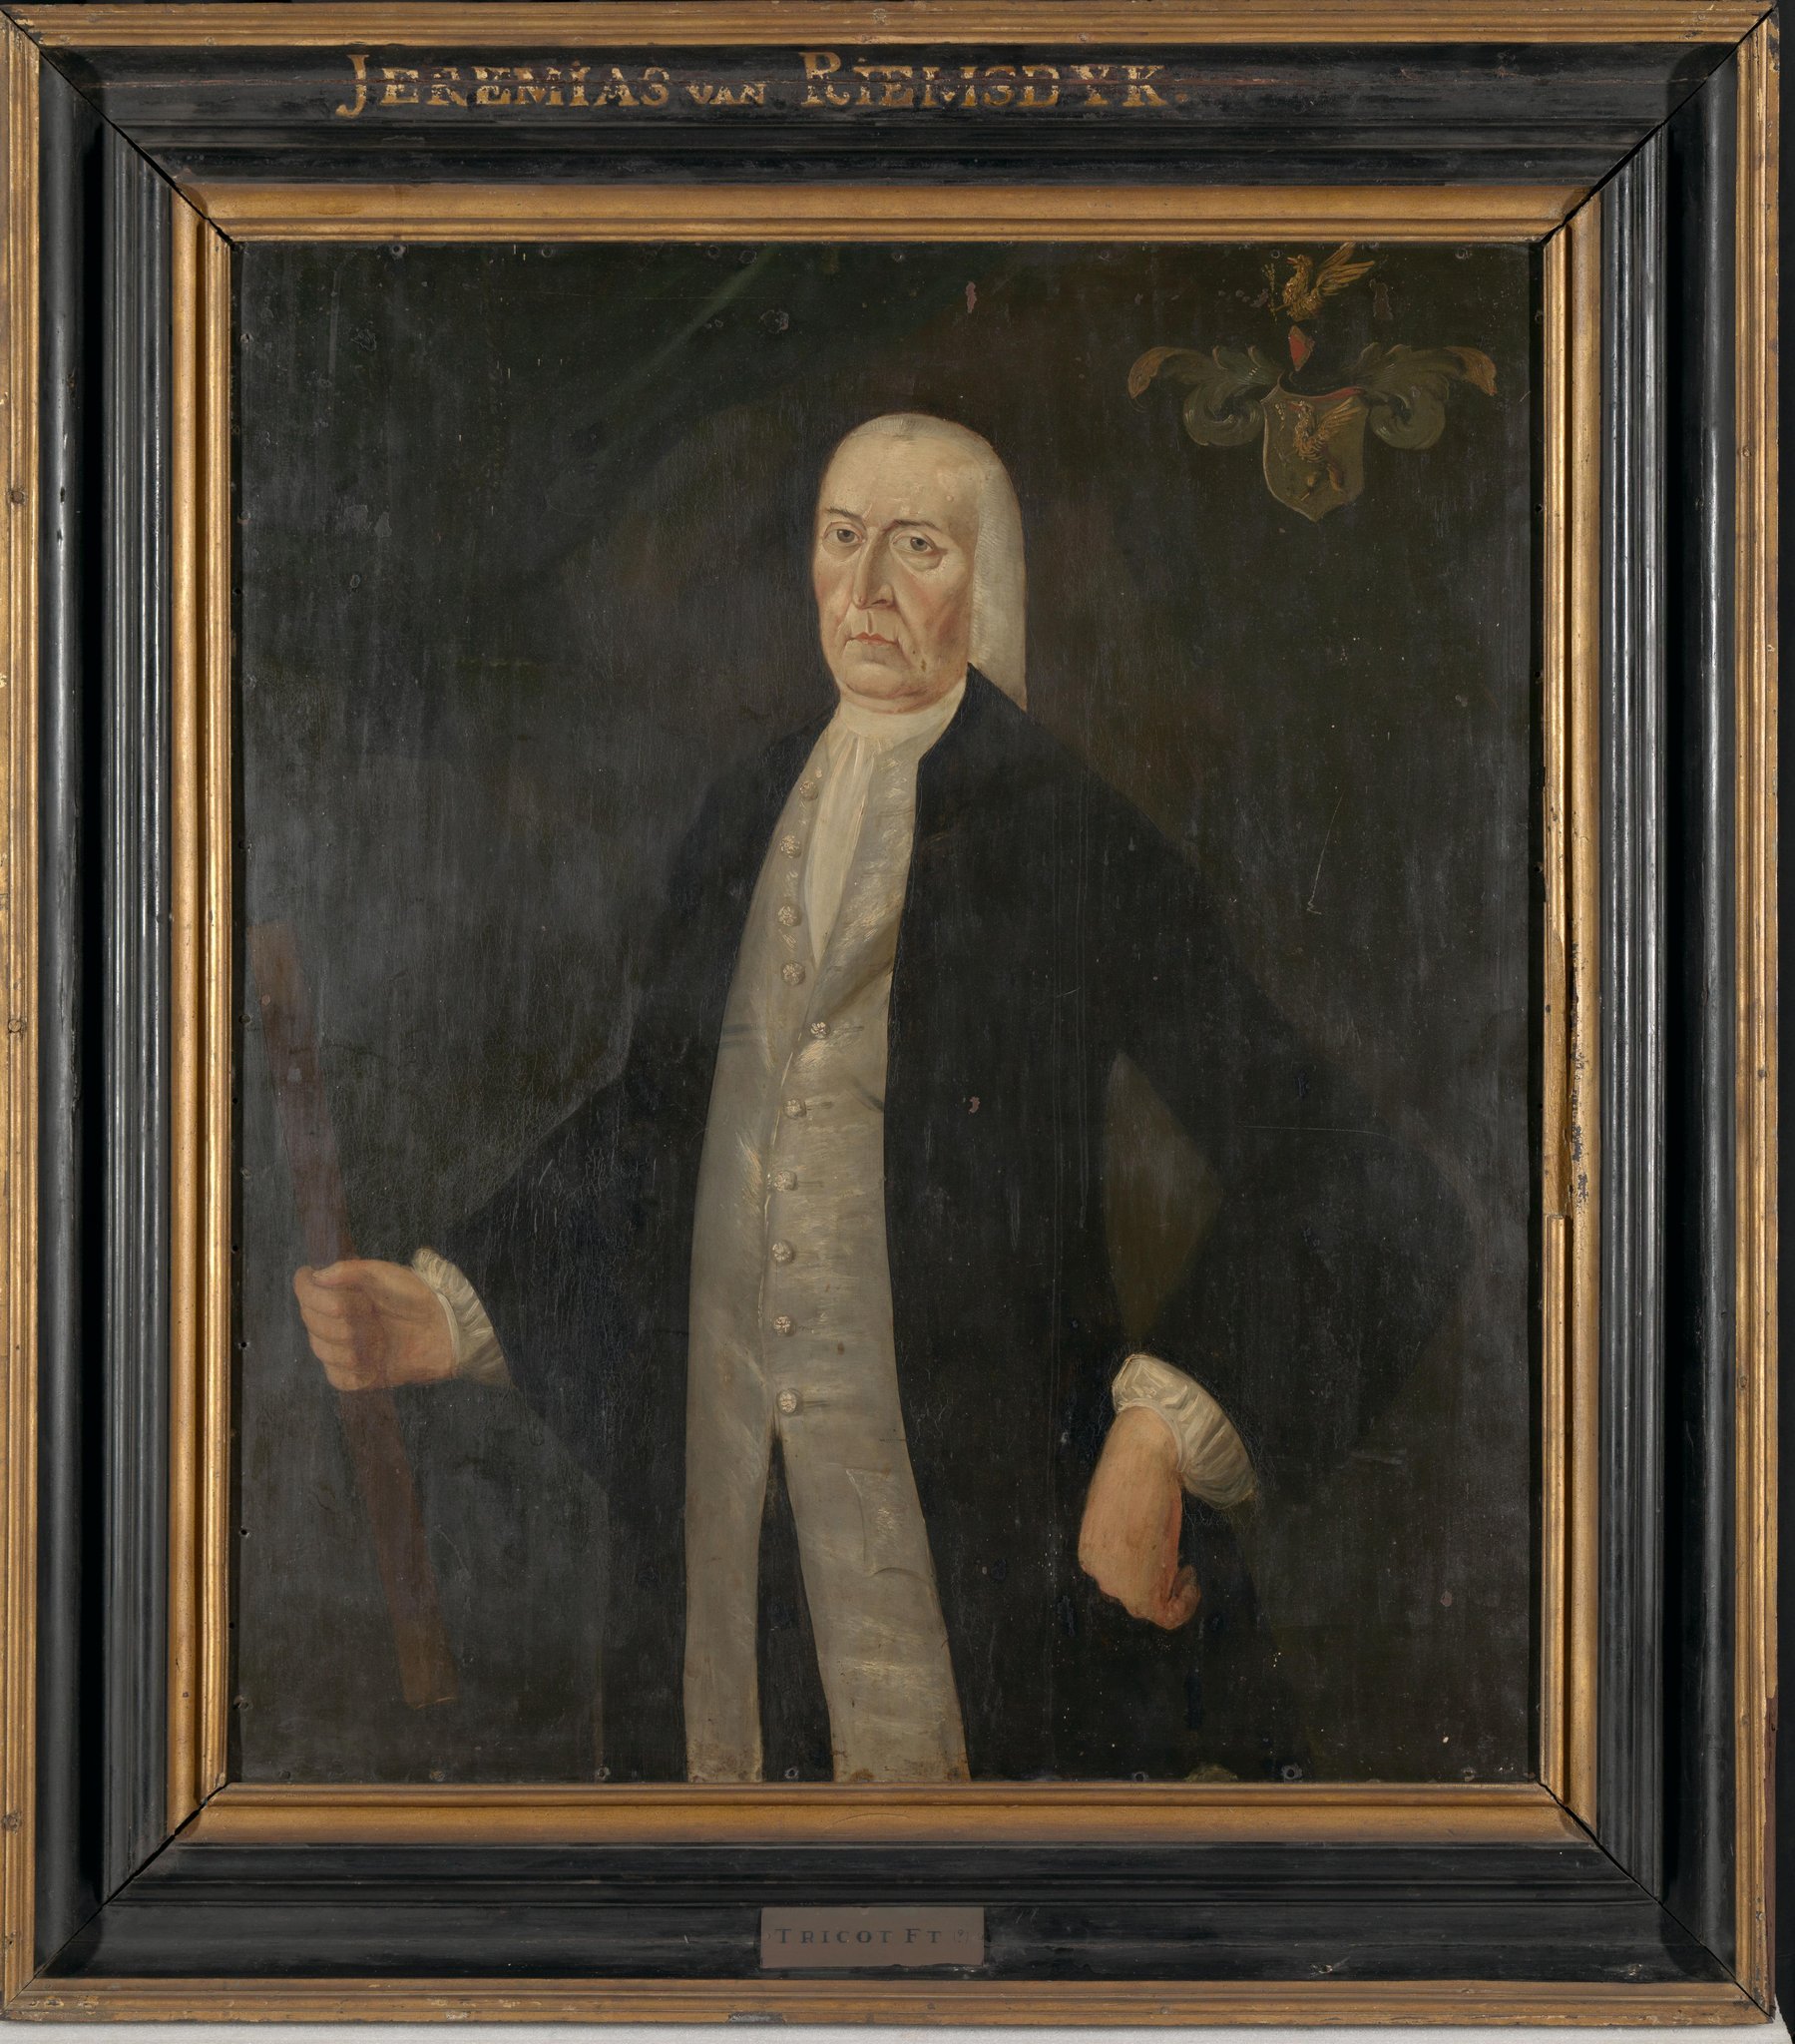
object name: painting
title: Portrait of Jeremias van Riemsdijk, Governor-General of the Dutch East India Company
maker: franciscus josephus fricot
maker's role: painter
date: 1775-1777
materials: brass, oil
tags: utrecht, batavia, colonial governor, historical persons, baton of general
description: Portret van Jeremias van Riemsdijk (1712-77). Gouverneur-generaal (1775-77). Heupstuk, staande naar links. Commandostaf in de rechterhand, de linkerhand in de zij. Rechtsboven het familiewapen. Onderdeel van een reeks van portretten van de gouverneurs-generaal van het voormalige Nederlands Oost-Indië.